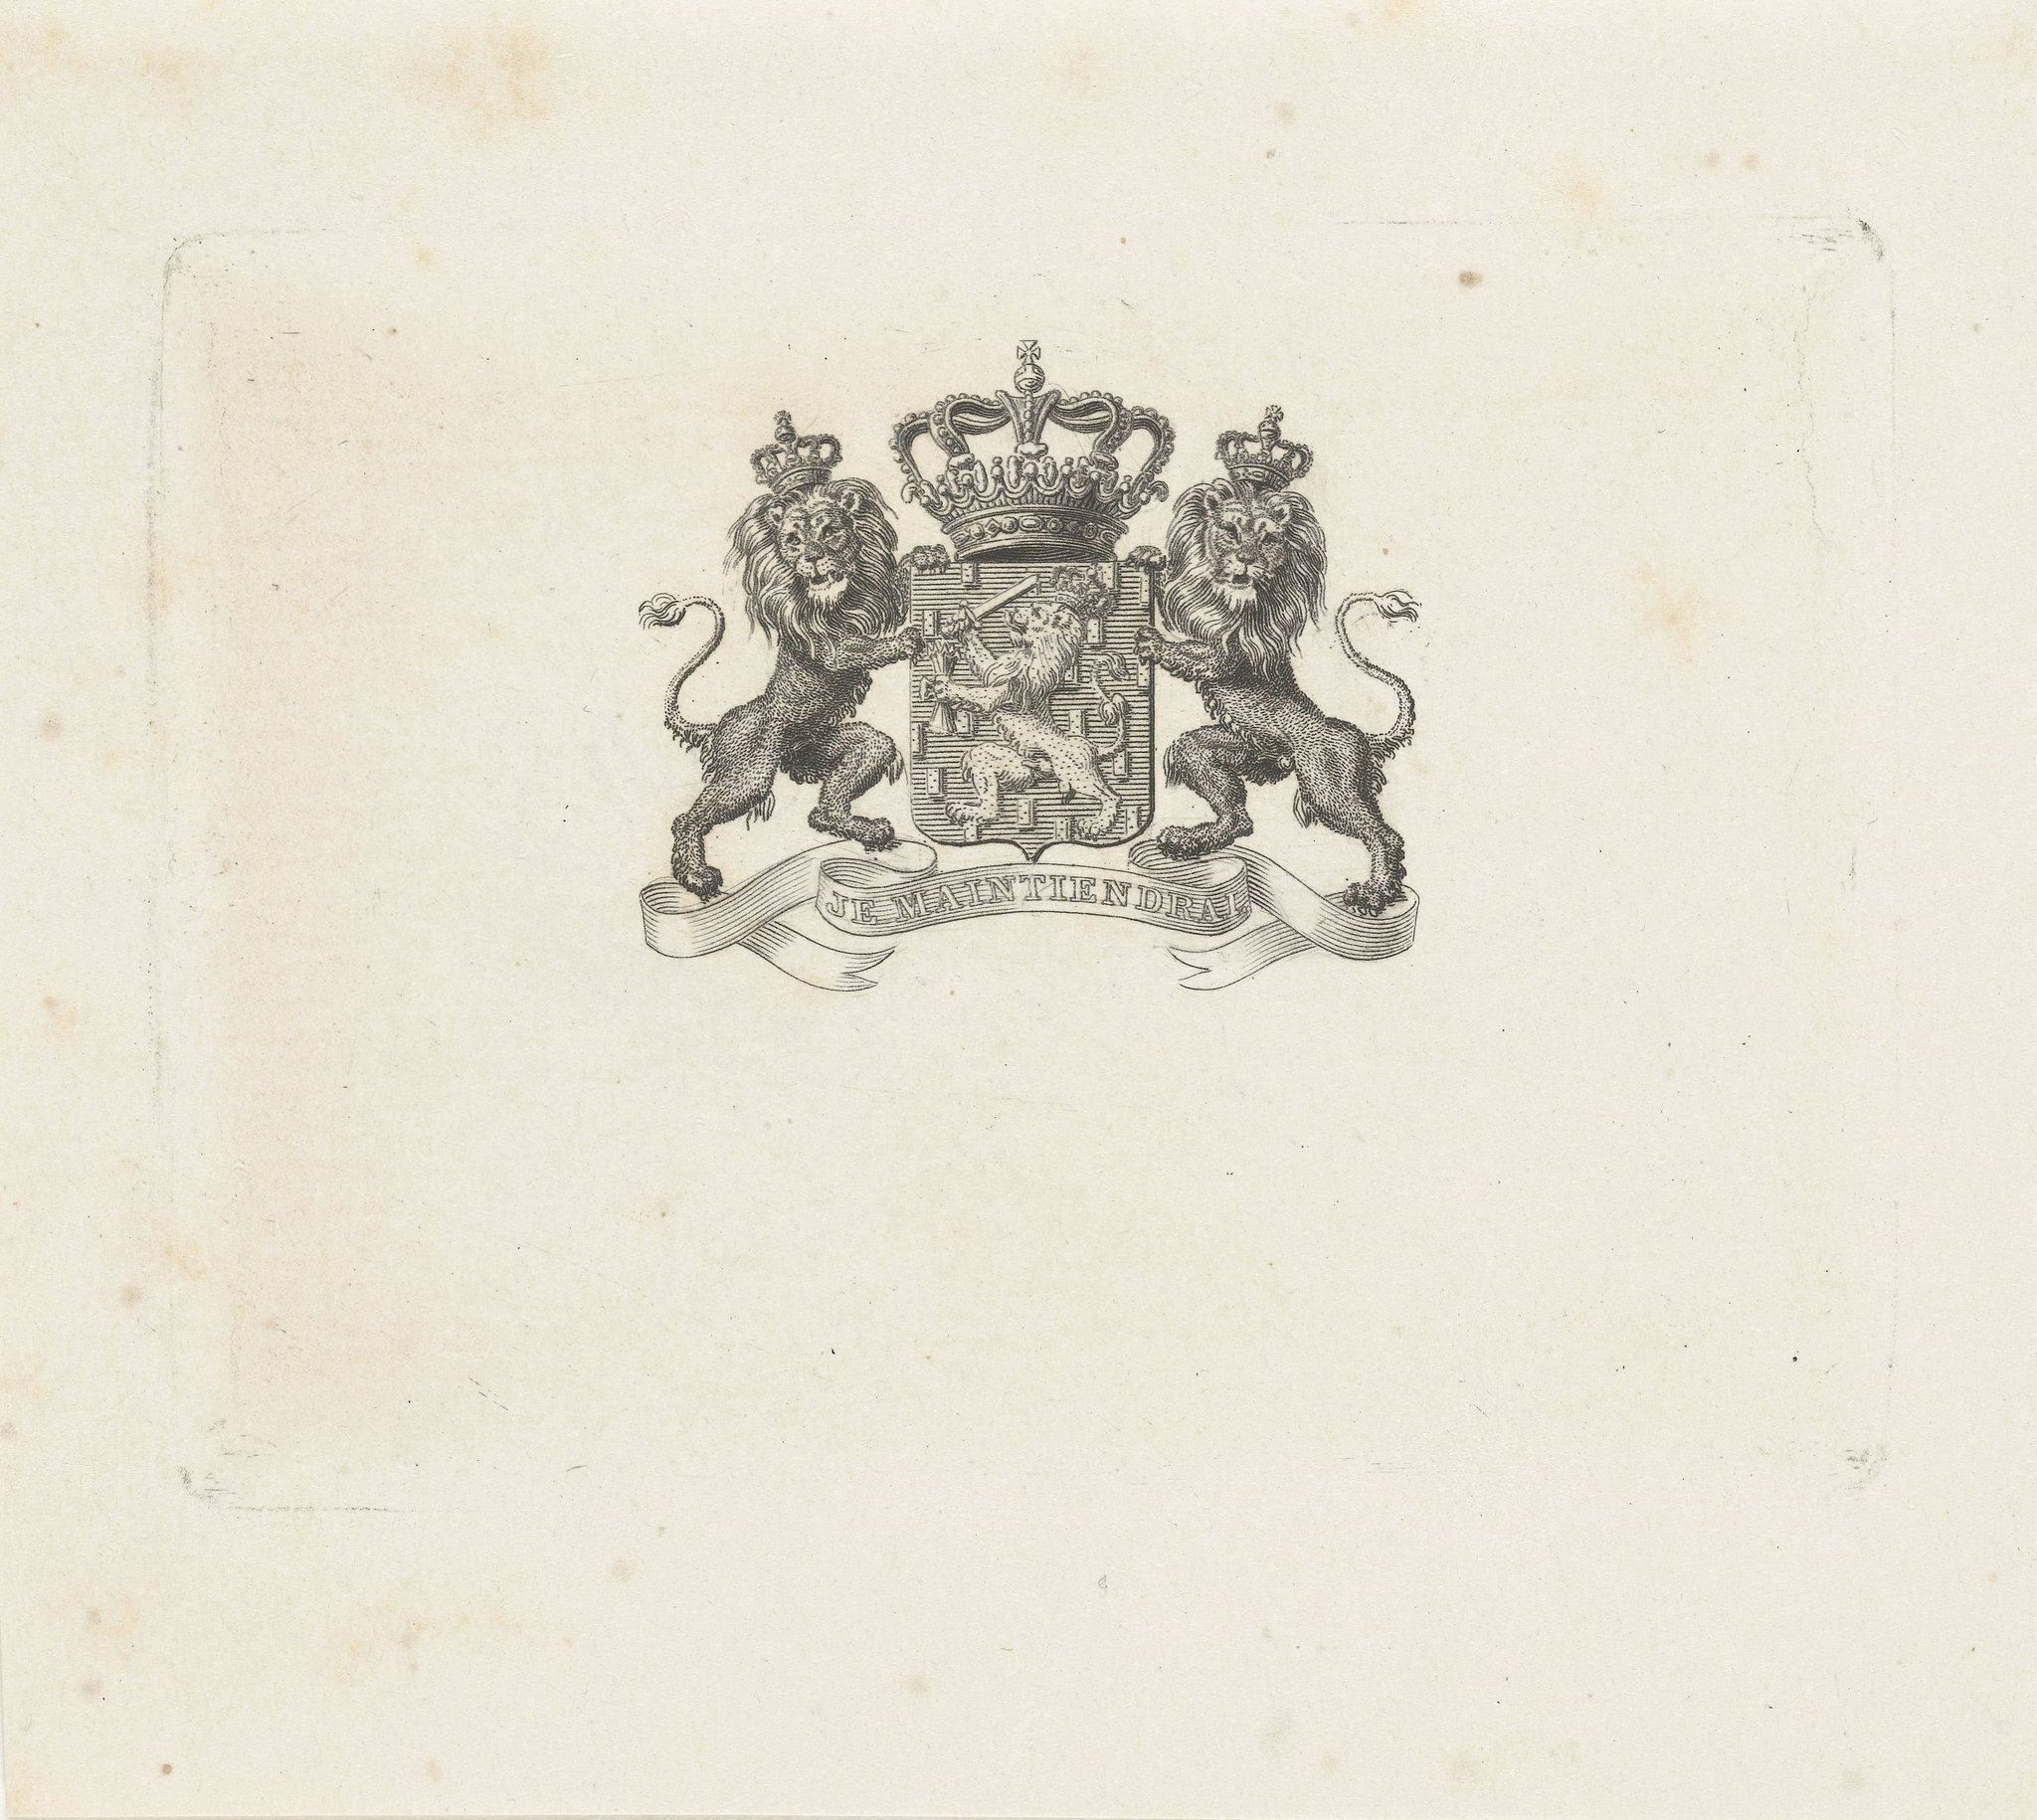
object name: print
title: Wapen van Nederland met motto: Je Maintiendrai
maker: henricus wilhelmus couwenberg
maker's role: draughtsman, print maker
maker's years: 1814-1845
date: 1830-1845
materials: paper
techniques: etching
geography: amsterdam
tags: coat of arms (as symbol of the state, etc.)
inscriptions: collector's mark: Lugt 2228